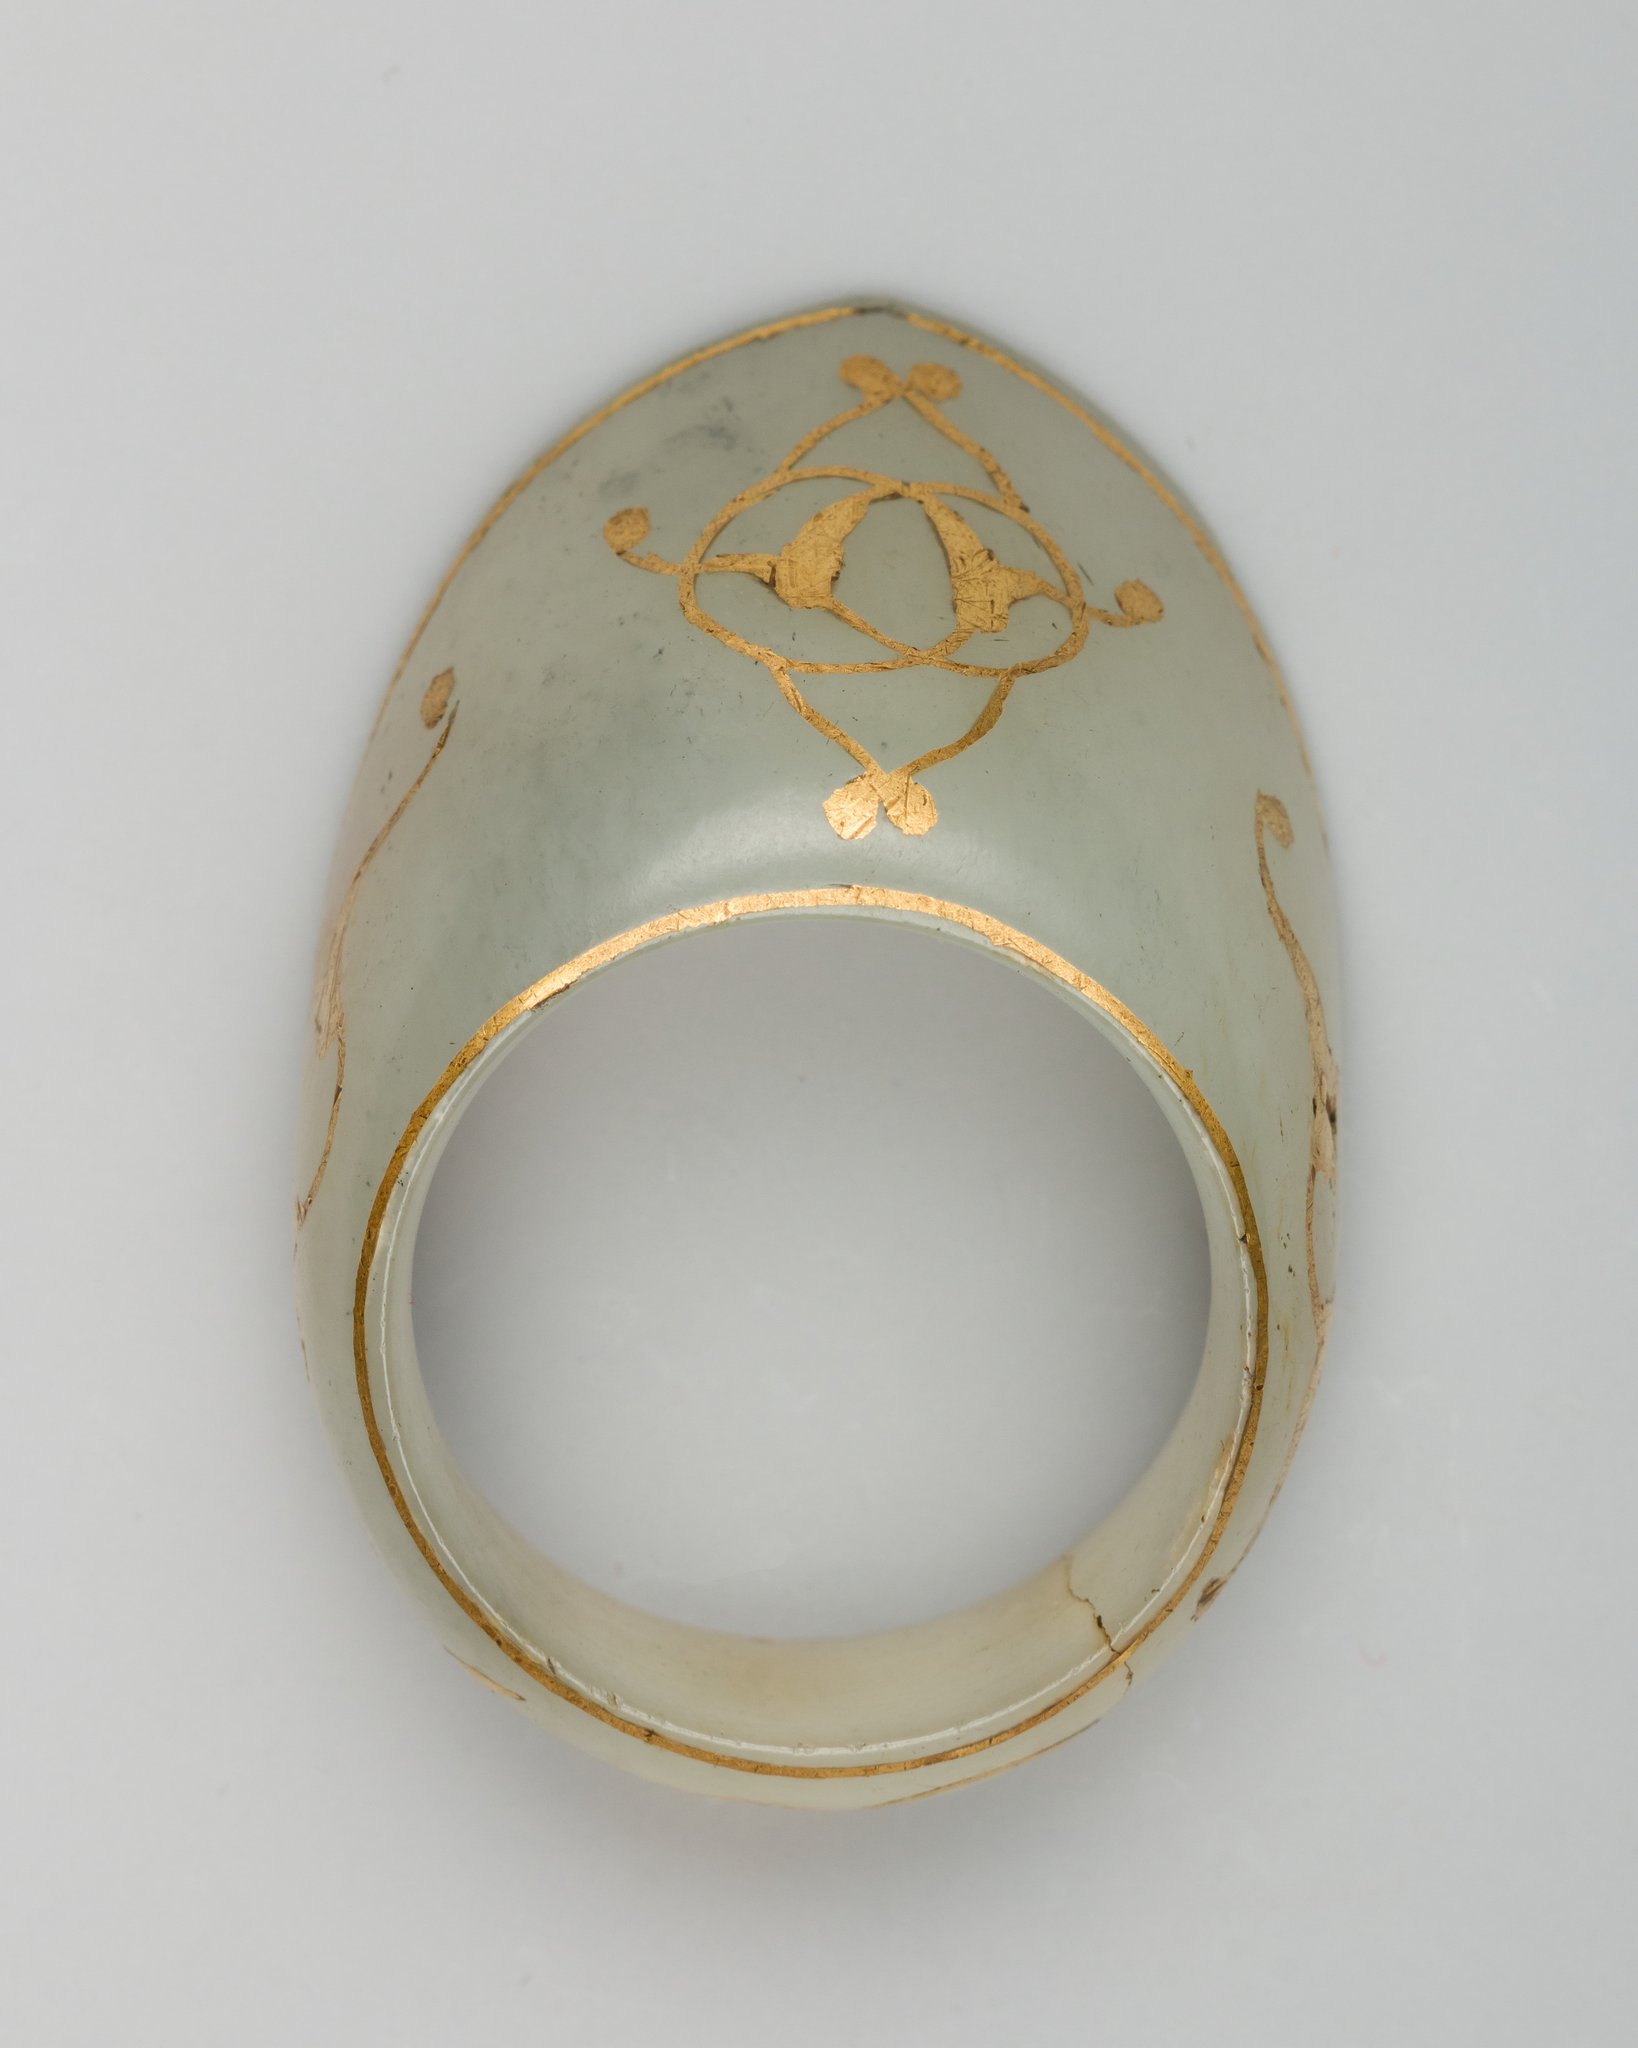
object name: archer's ring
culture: ottoman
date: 1567-1633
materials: gold, jade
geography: turkey